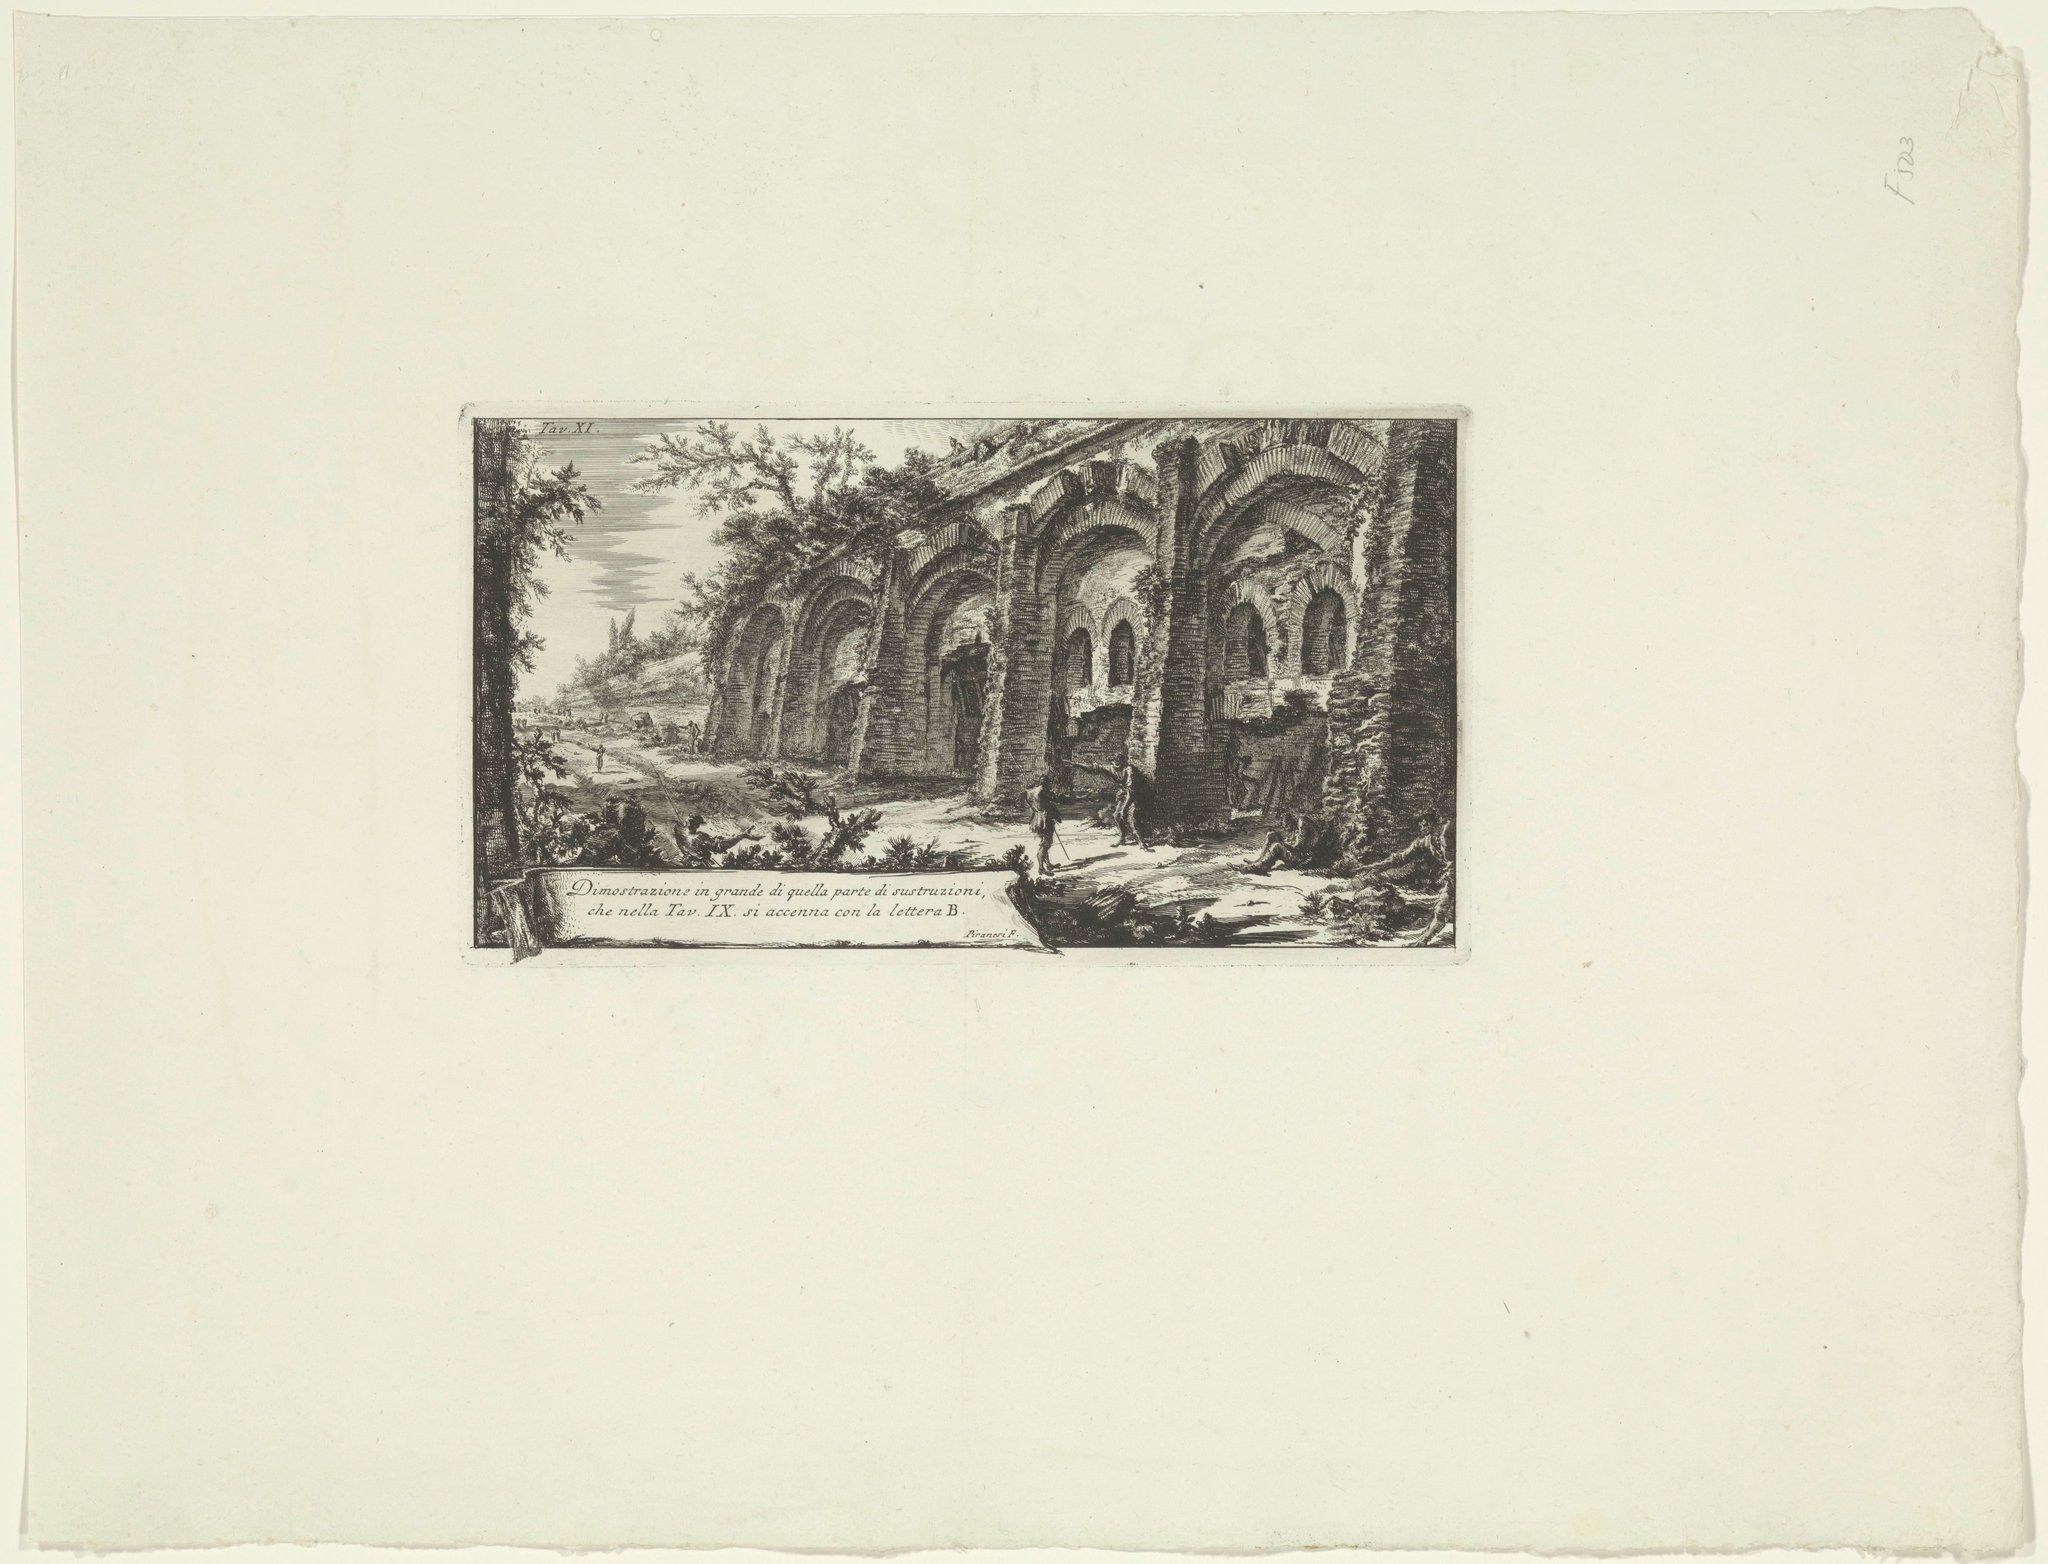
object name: print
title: Dimostrazione in grande di quella parte di sustruzion (...)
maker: giovanni battista piranesi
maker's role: designer, draughtsman, print maker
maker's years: 1720-1778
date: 1762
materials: paper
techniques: etching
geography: rome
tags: city-view, and landscape with man-made constructions, ruin of a building ~ architecture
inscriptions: collector's mark: Lugt 2228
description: Een bouwwerk met vijf bogen langs een weg. Volgens de titel die verwijst naar een andere prent uit dezelfde serie gaat het om funderingen van de Villa van Clodio in de Albaanse Heuvels, later in bezit van de familie Barberini. Titel linksonder. Genummerd linksboven: Tav. XI.